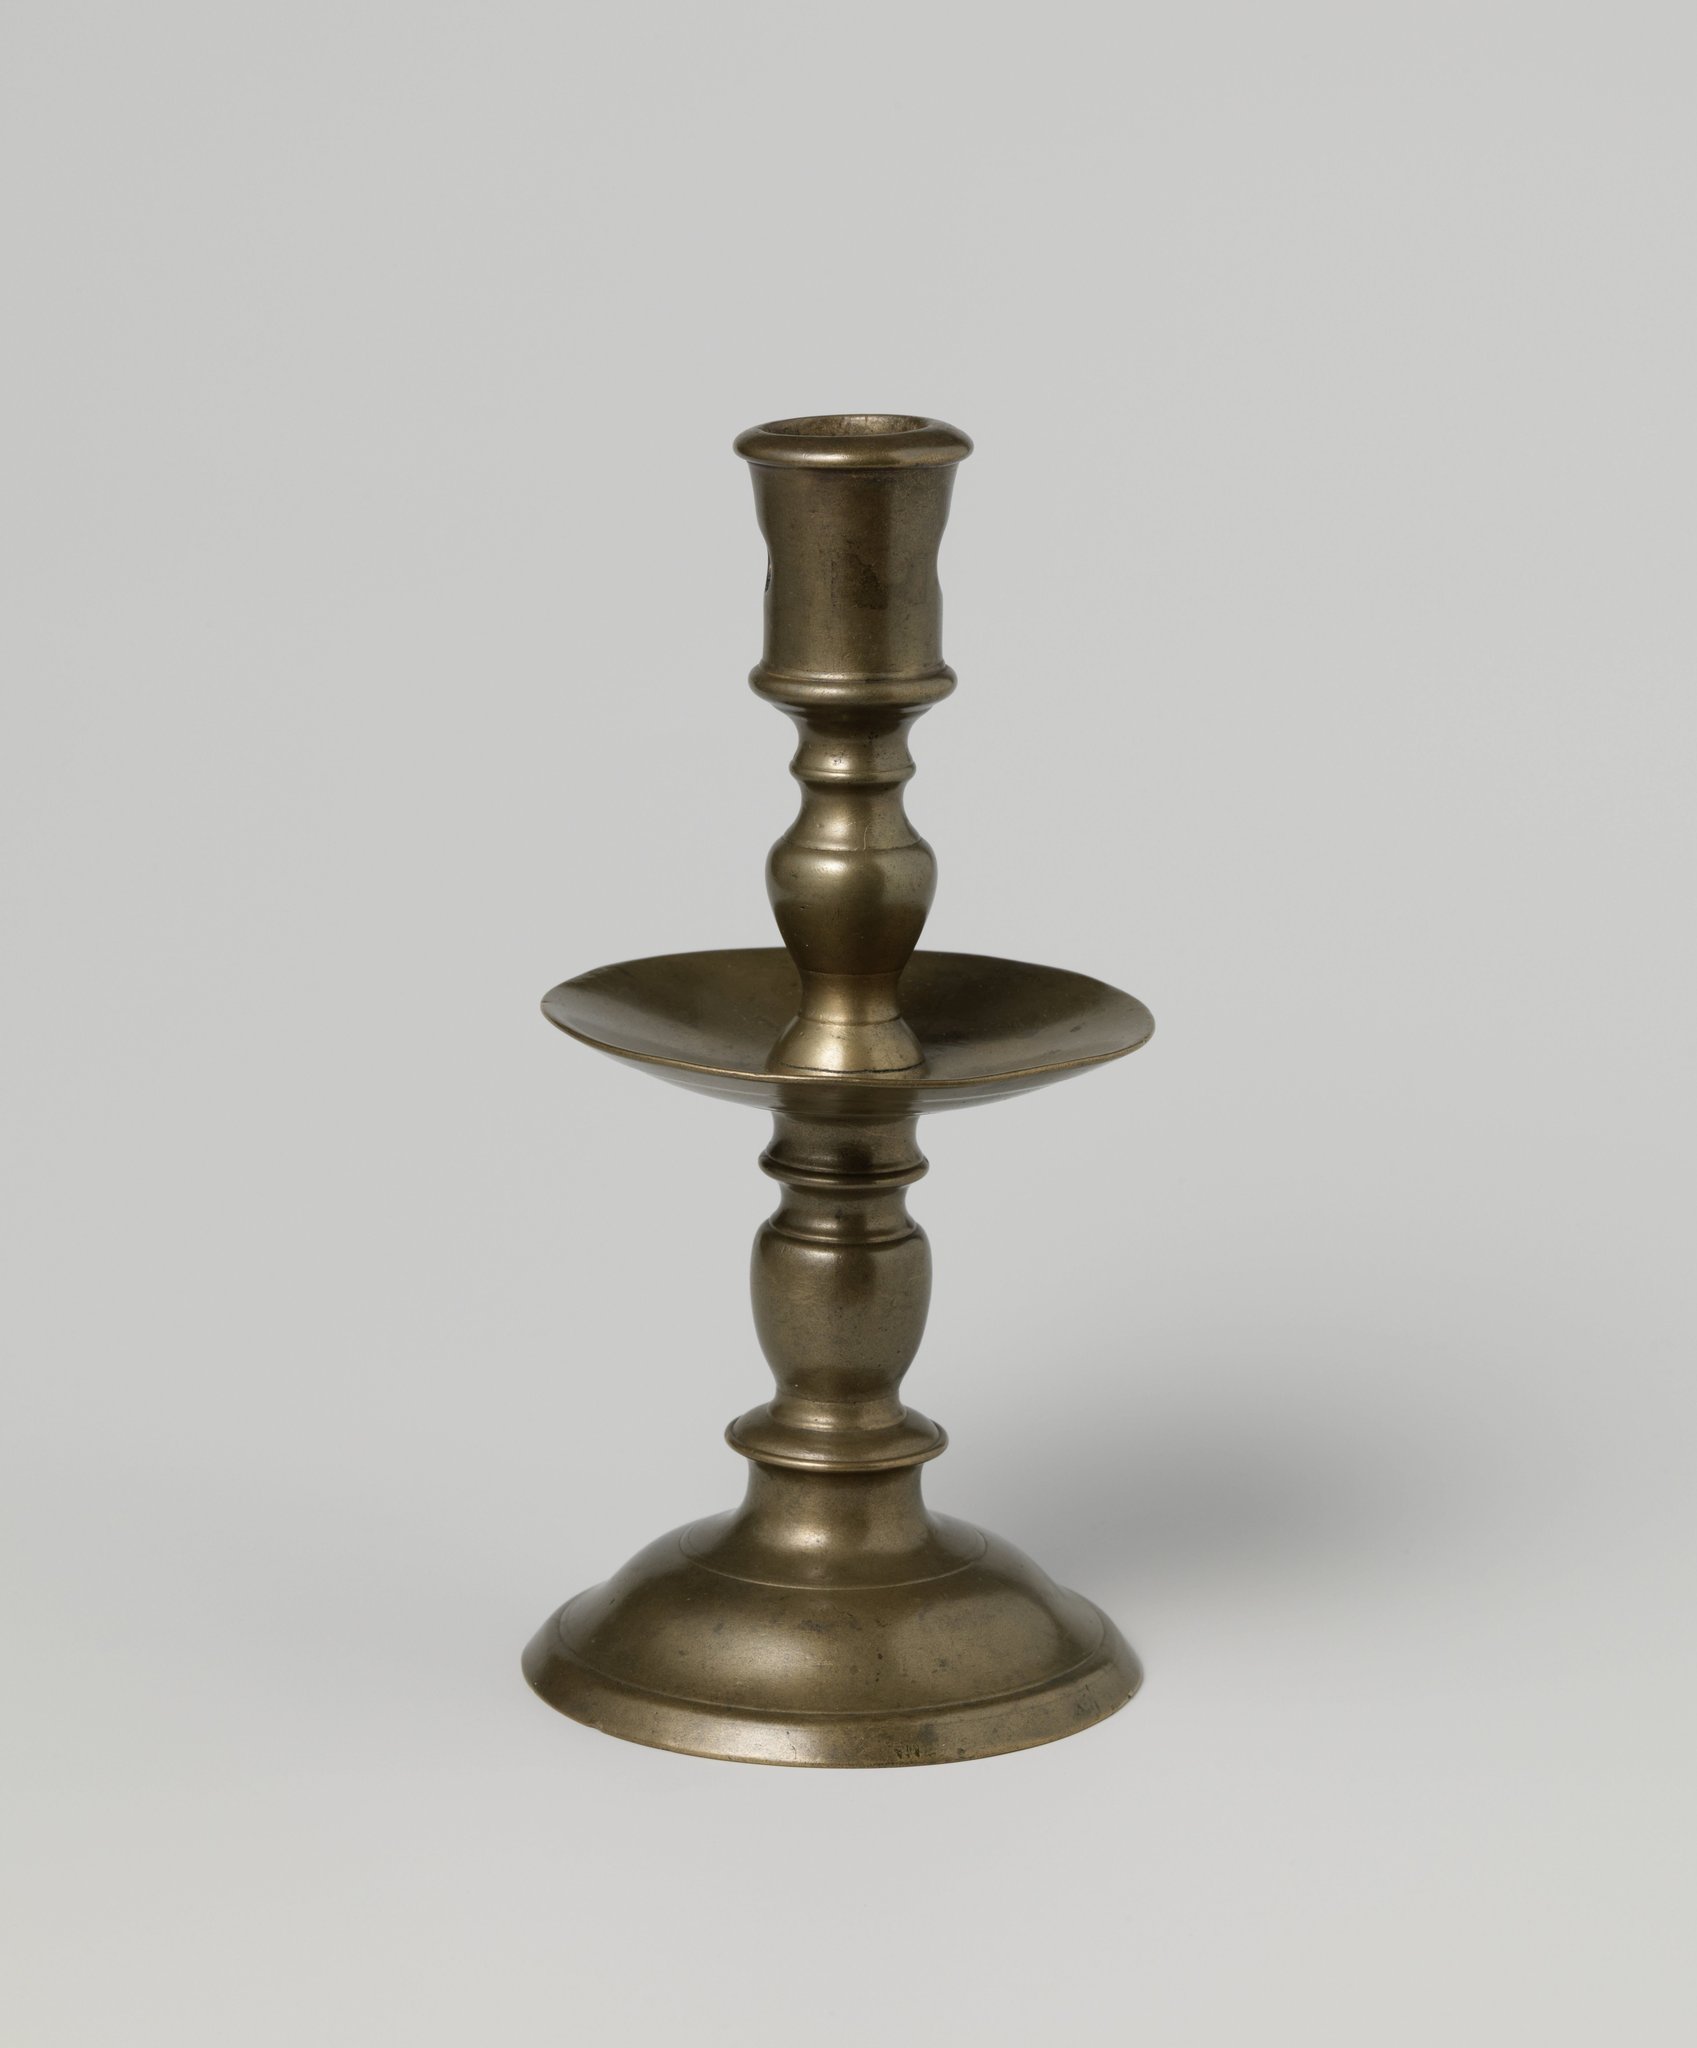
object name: candlestick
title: Kraag- of schijfkandelaar van messing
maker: Anonymous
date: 1575-1625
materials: brass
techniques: casting, riveted, turning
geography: northern netherlands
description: De kandelaar is samengesteld uit twee gegoten en afgedraaide delen: de voet met het onderste deel van de stam en de vetvanger en vervolgens het bovenste deel van de stam en de kaarsenhouder. De bovenhelft is met een pin in de voet vastgeklonken. Het onderste stuk bestaat uit een ronde geprofileerde voet, een balustervormige stam en een aan de onderkant geprofileerde vetvanger, de kraag. Het bovendeel bestaat uit een balustervormige stam en een geprofileerde cylindrische houder, welke in het midden van de wand twee in elkaars verlengde aangebrachte ronde gaten heeft. Aan de onderkant van de voet zijn de draairingen te zien.